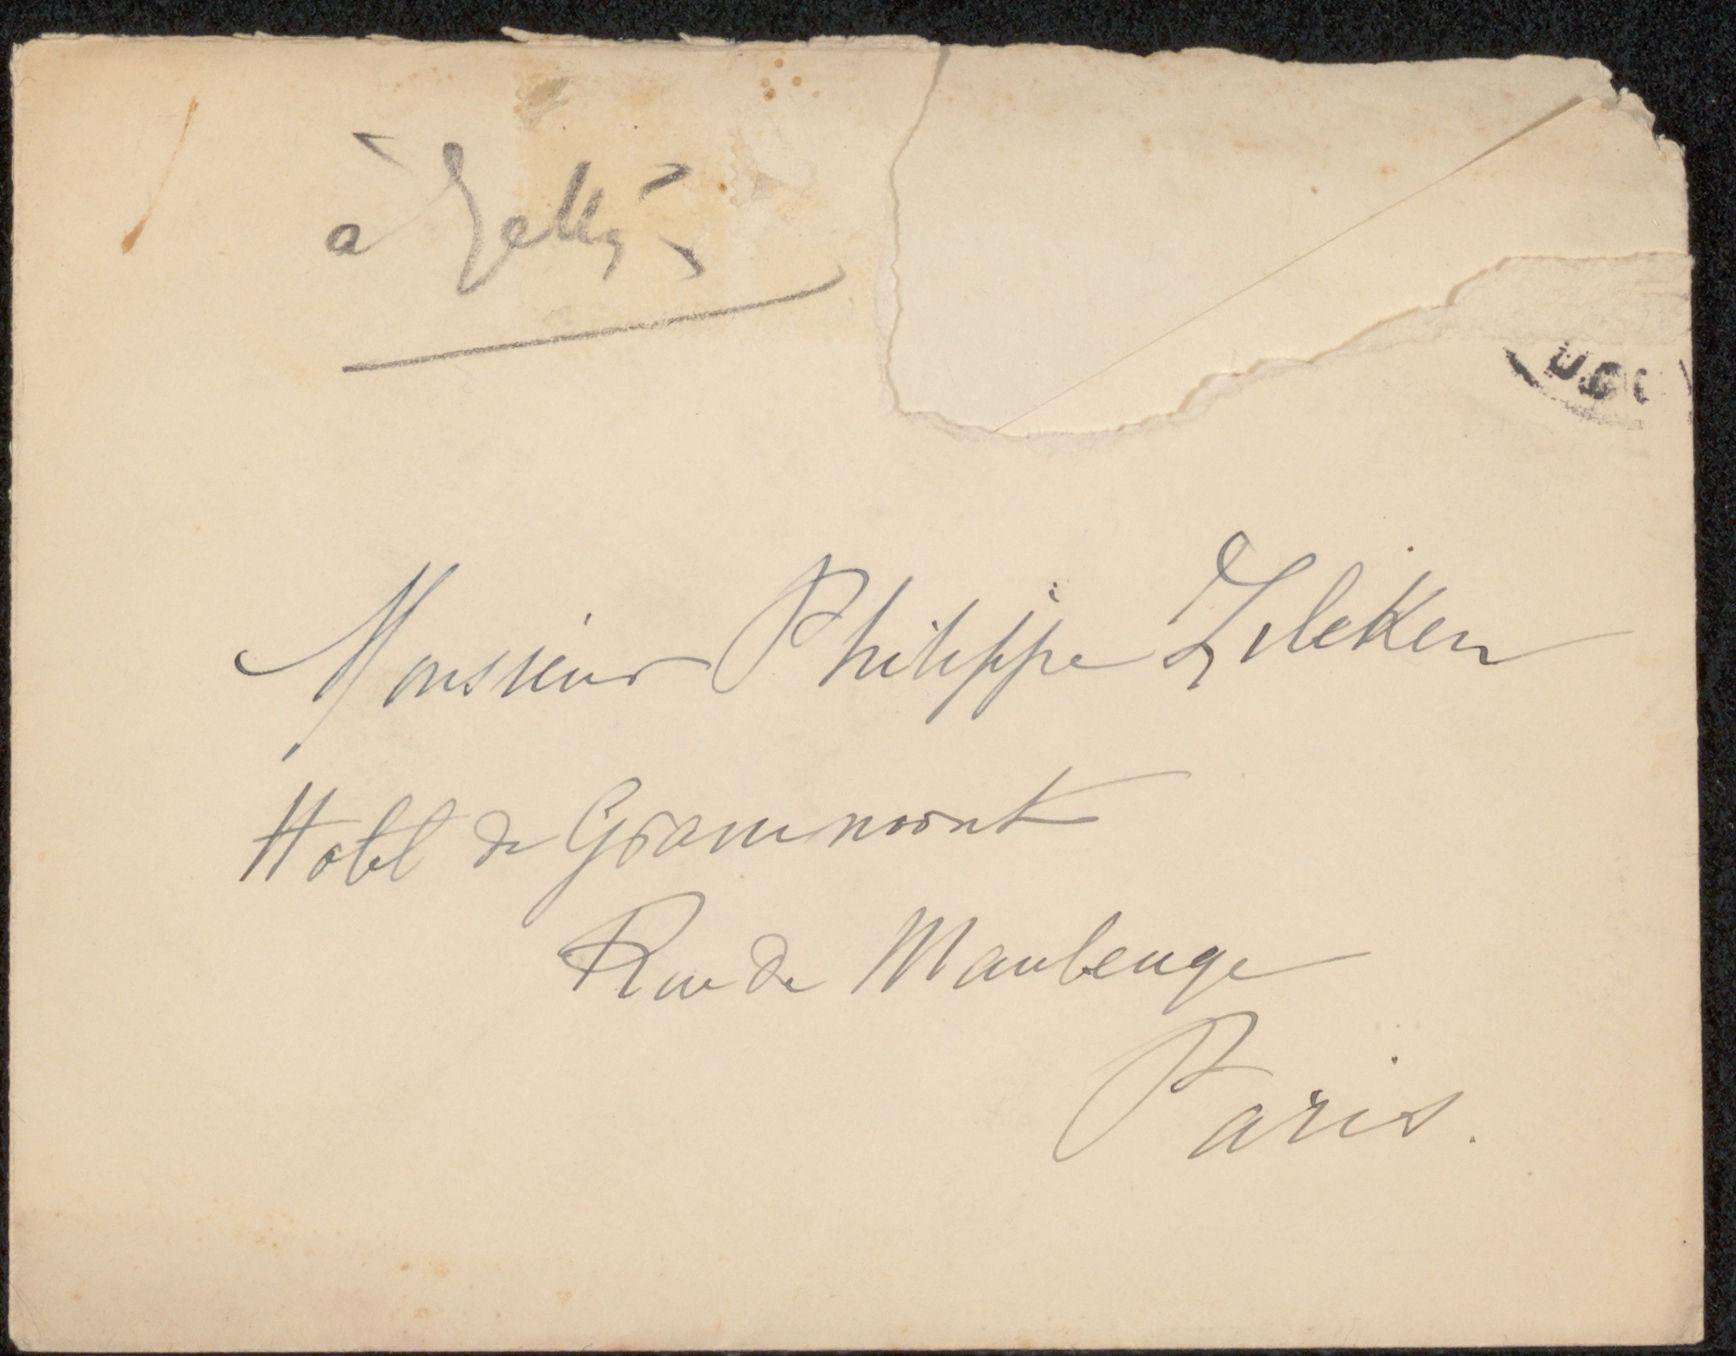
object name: envelope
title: Envelop aan Philip Zilcken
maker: jeanne boels de buck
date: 1867-1930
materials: ink, paper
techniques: pen, writing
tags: the hague, painter, draughtsman, philip zilcken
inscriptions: collector's mark: ‘RPK’